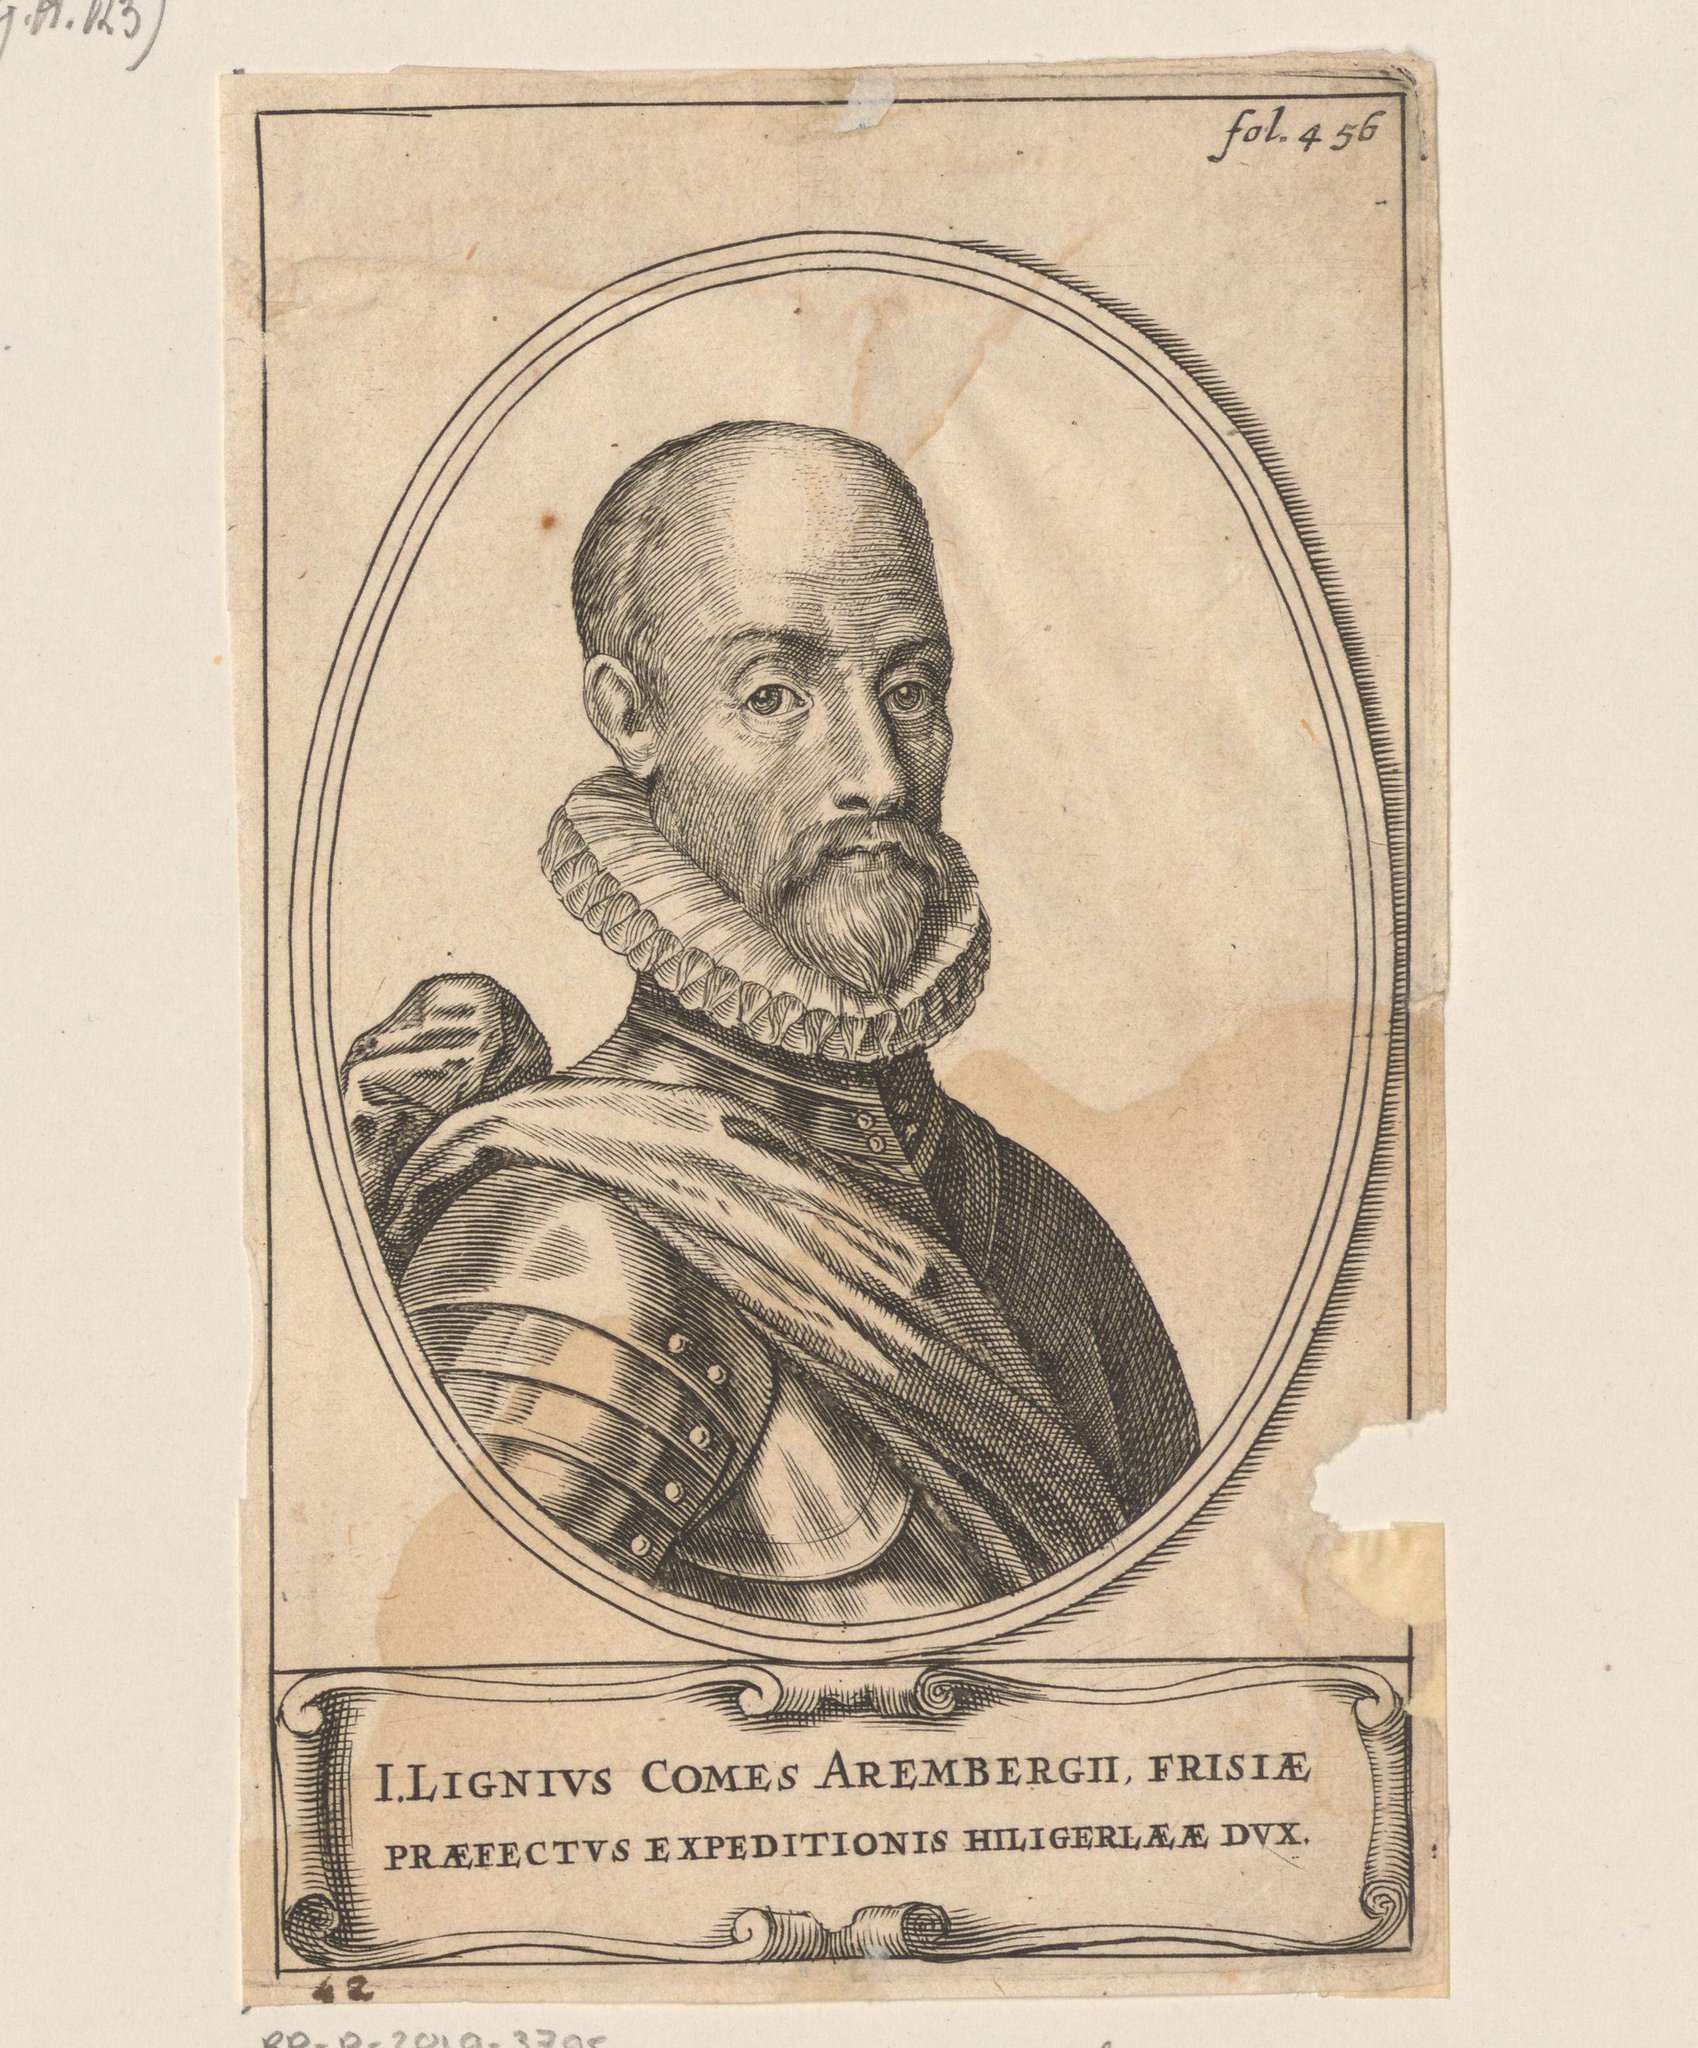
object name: print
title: Portret van Jean de Ligne, graaf van Arenberg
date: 1666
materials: paper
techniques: engraving, etching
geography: amsterdam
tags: albert de ligne (prins van barbançon en arenberg), armour, historical persons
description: Prent uit: Strada, Famiano. De thien eerste boecken der Nederlandsche oorlogen. Amsterdam: Abraham Wolfgang, 1666.